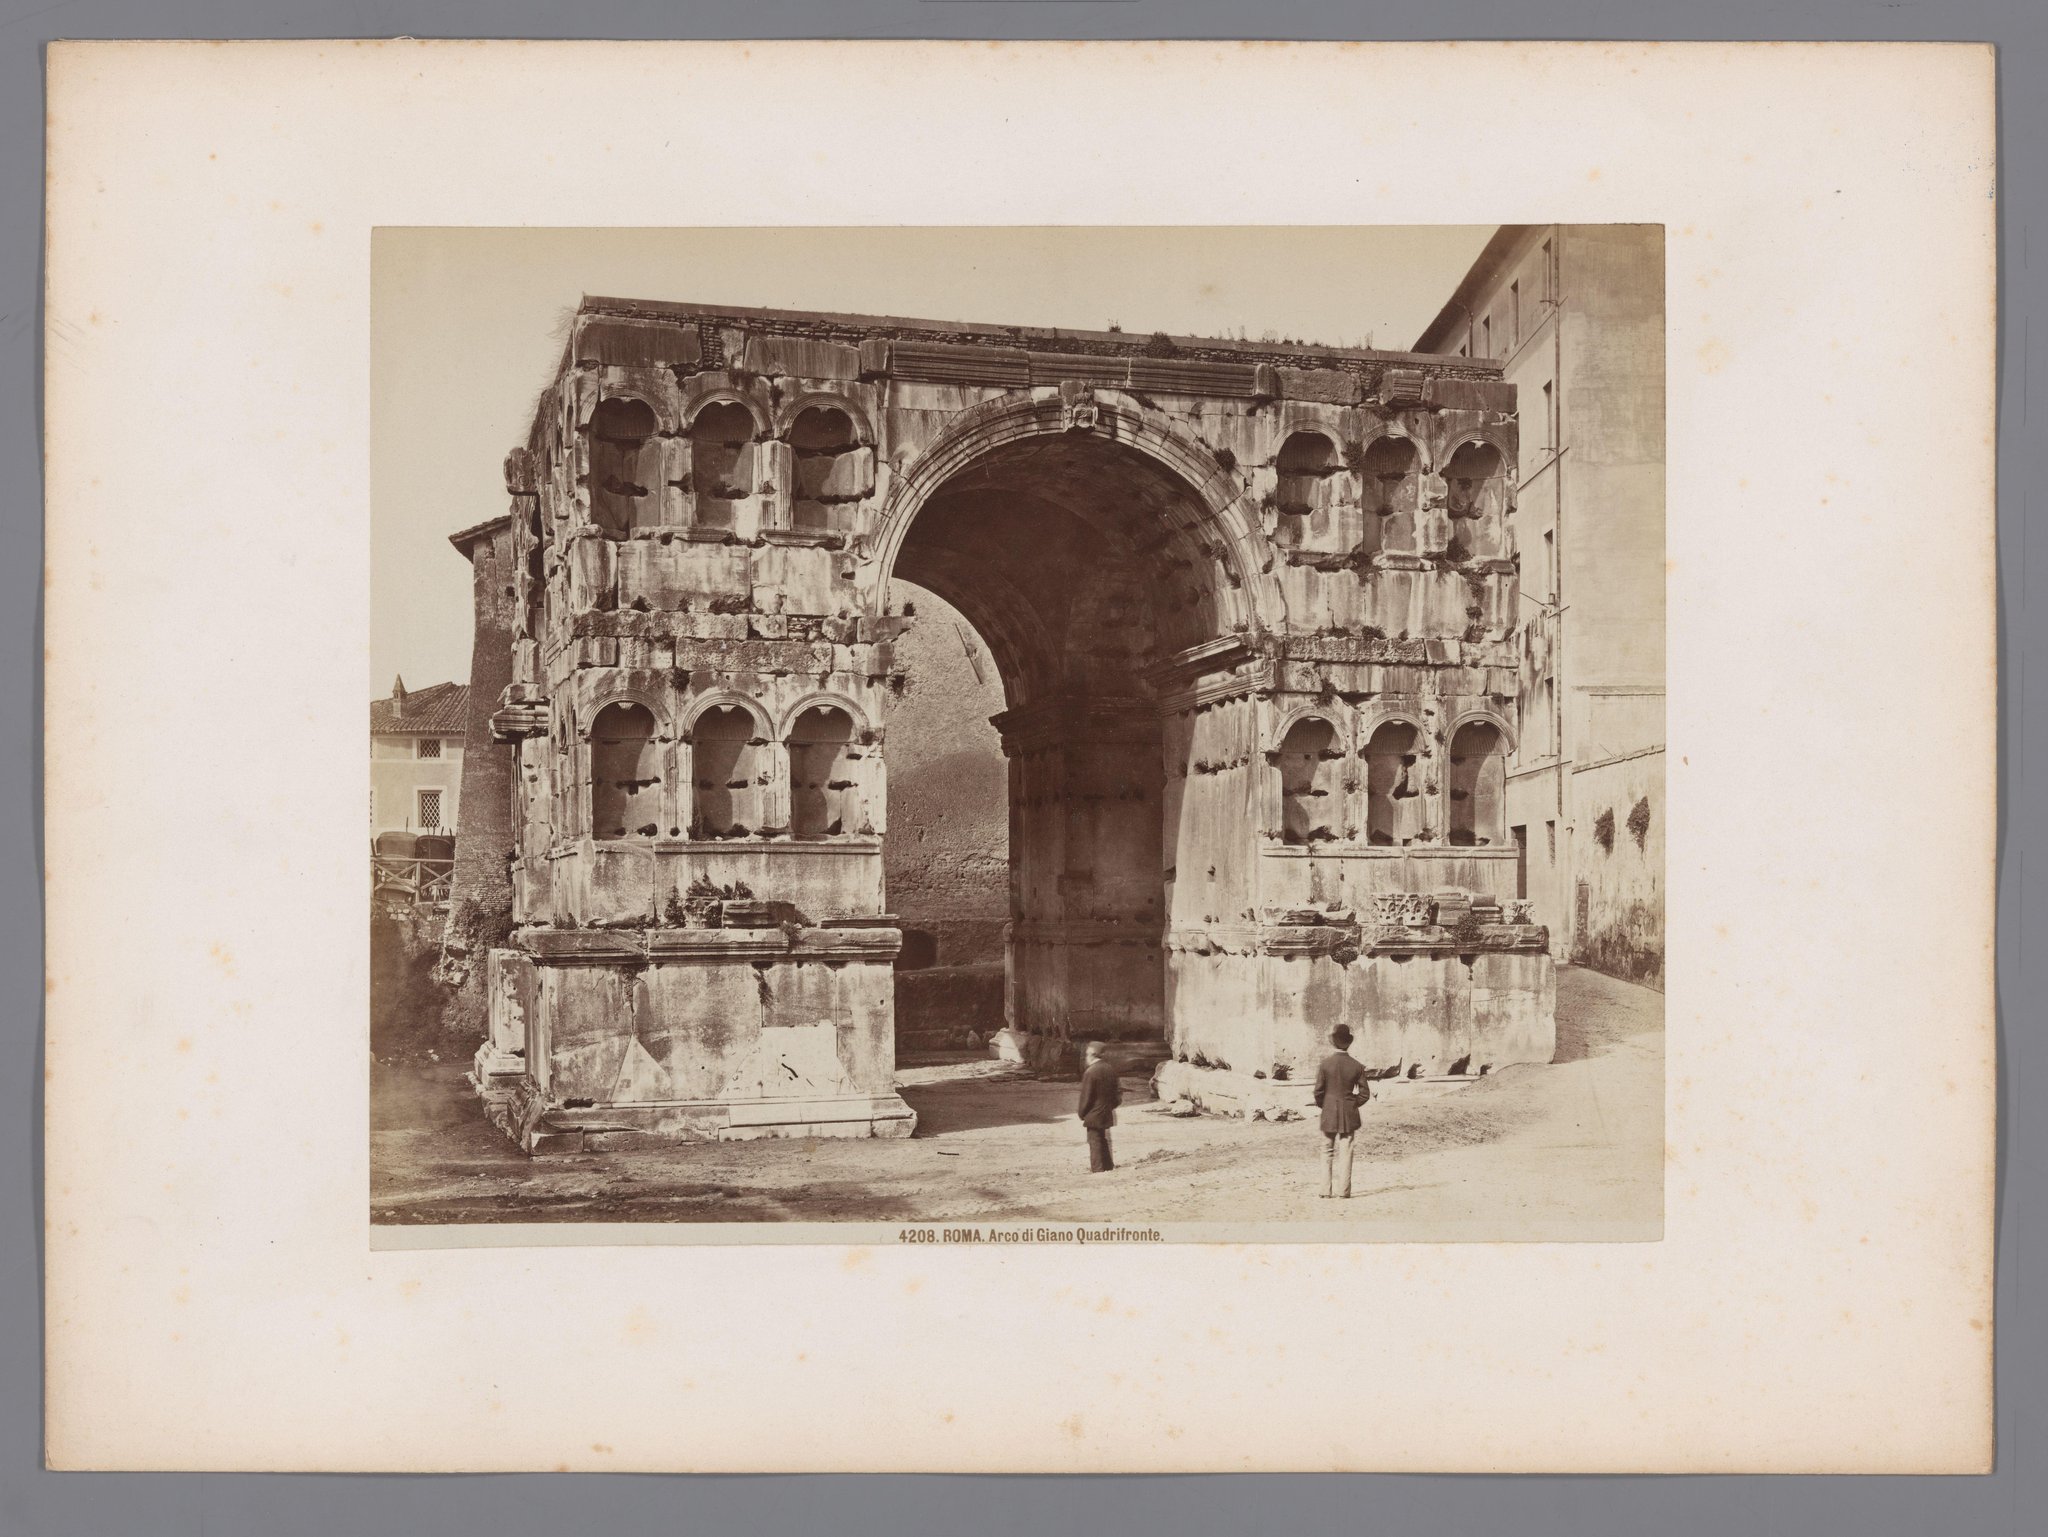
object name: photograph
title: Roma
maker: Anonymous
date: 1851-1900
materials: cardboard, paper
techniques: albumen print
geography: rome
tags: triumphal arch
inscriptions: number: ‘4208.’, number: ‘8’, inscription: ‘45-’